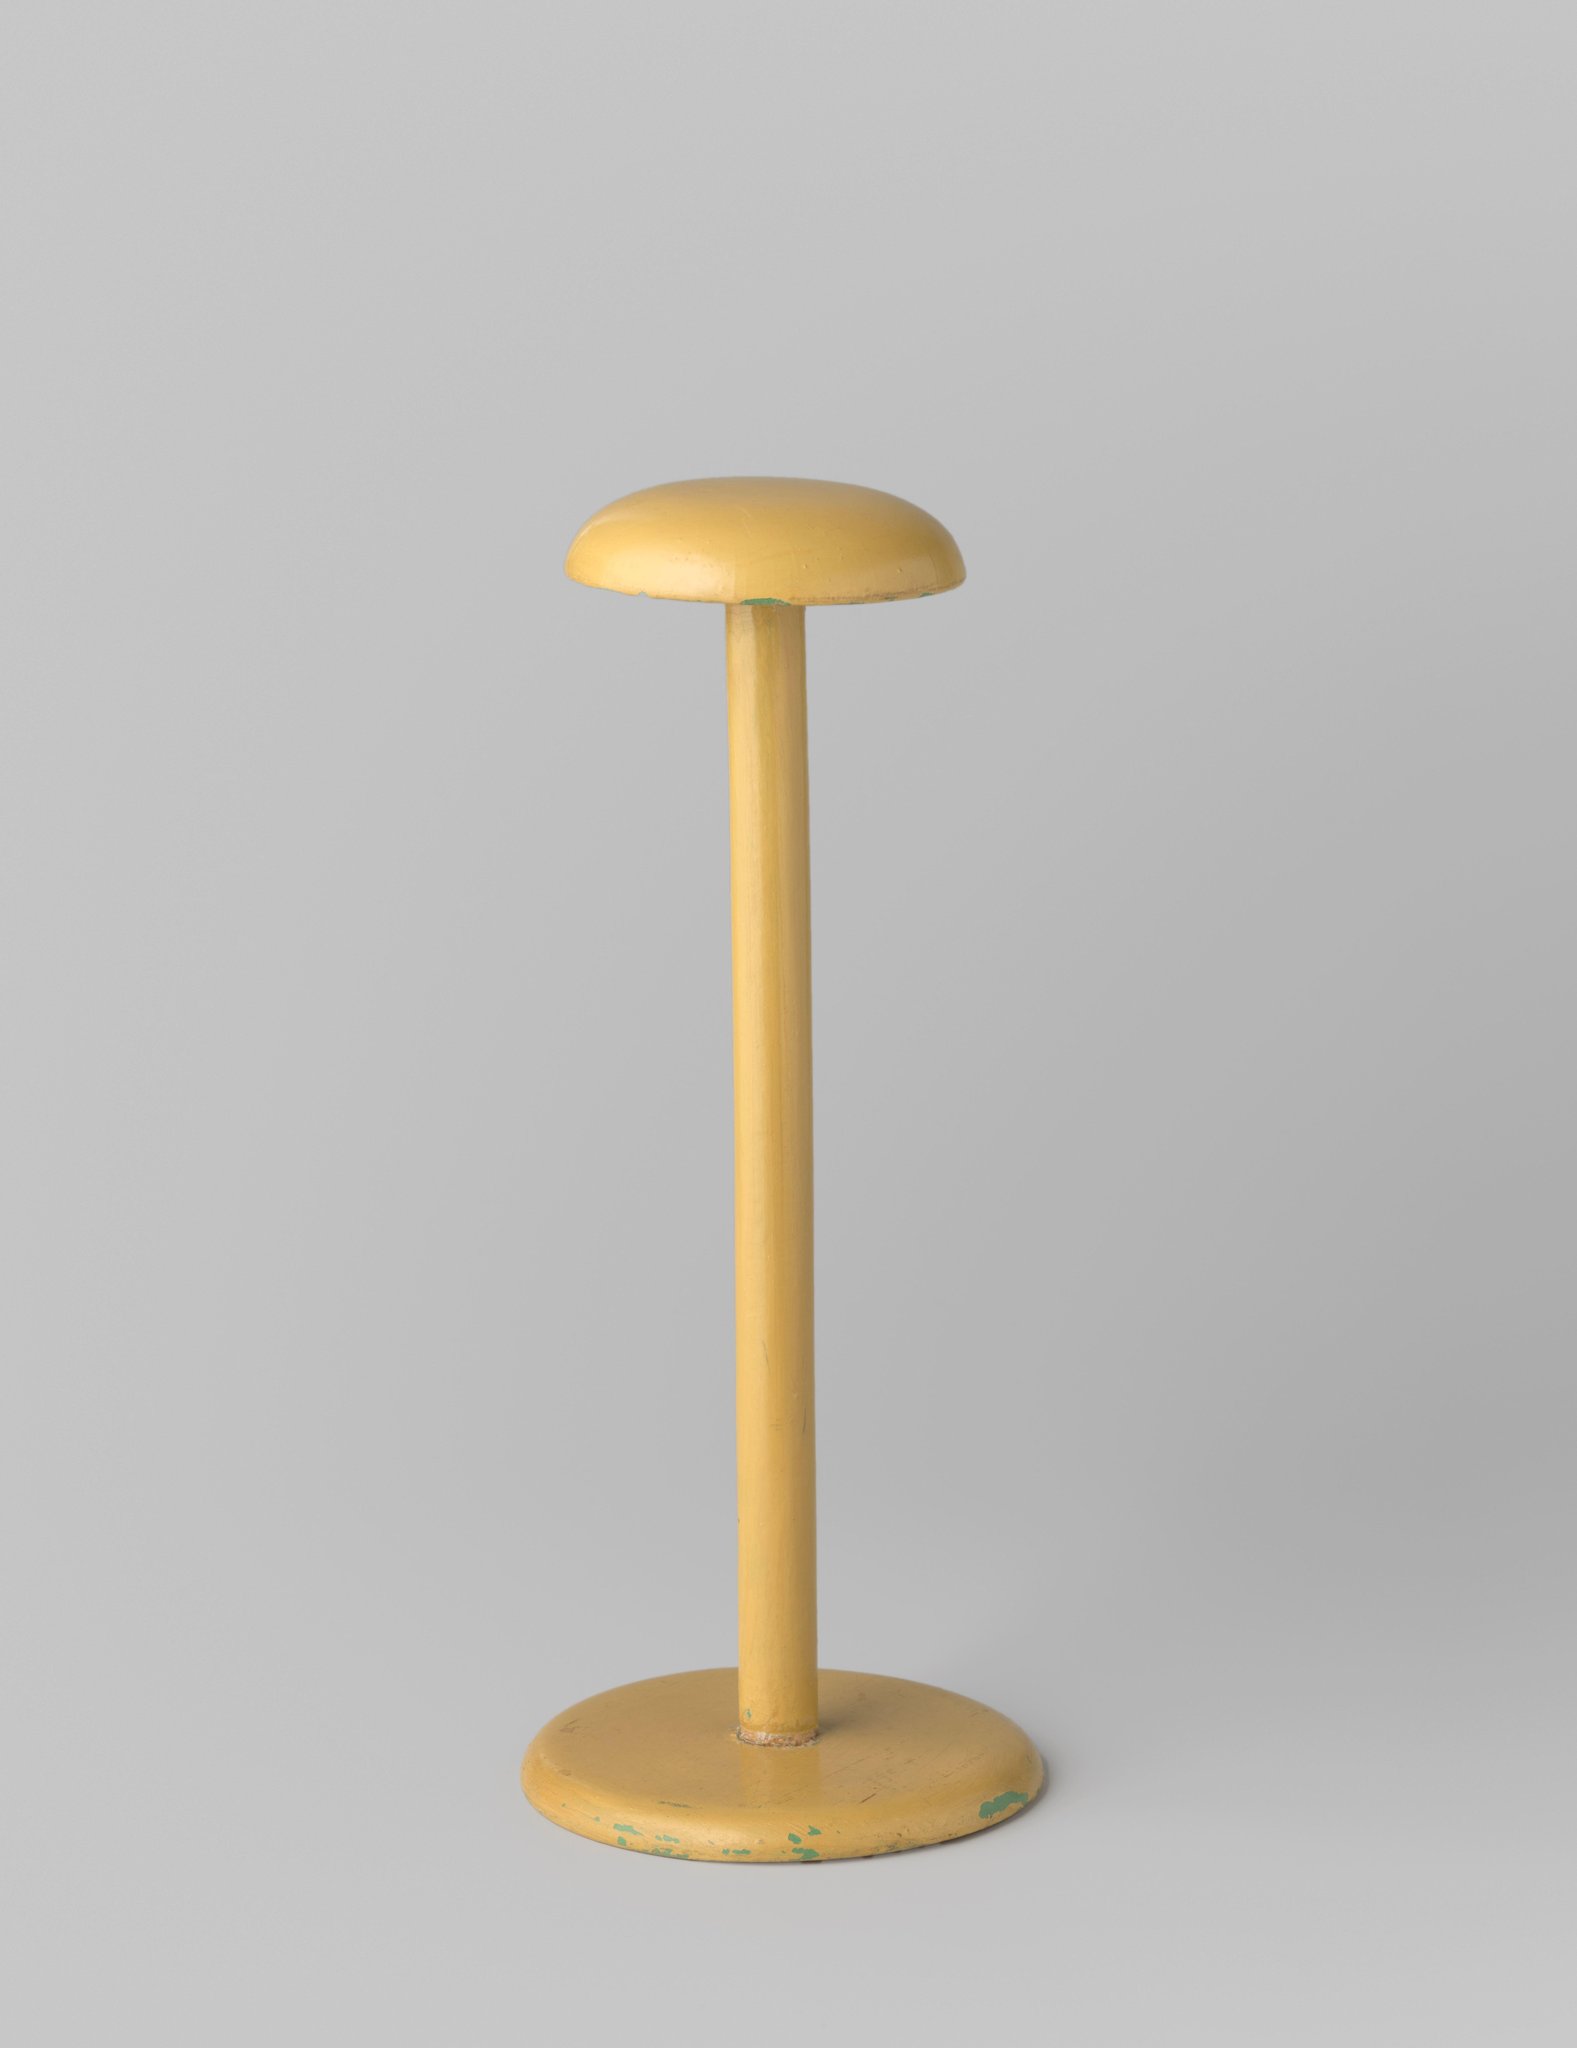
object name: womenswear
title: Hoedenstandaard van geel geschilderd hout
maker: Anonymous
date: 1950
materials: wood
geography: western europe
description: Hoedenstandaard van geel geschilderd hout. De rechte stam rust op een gladde ronde voet, en draagt een bol draagvlak.